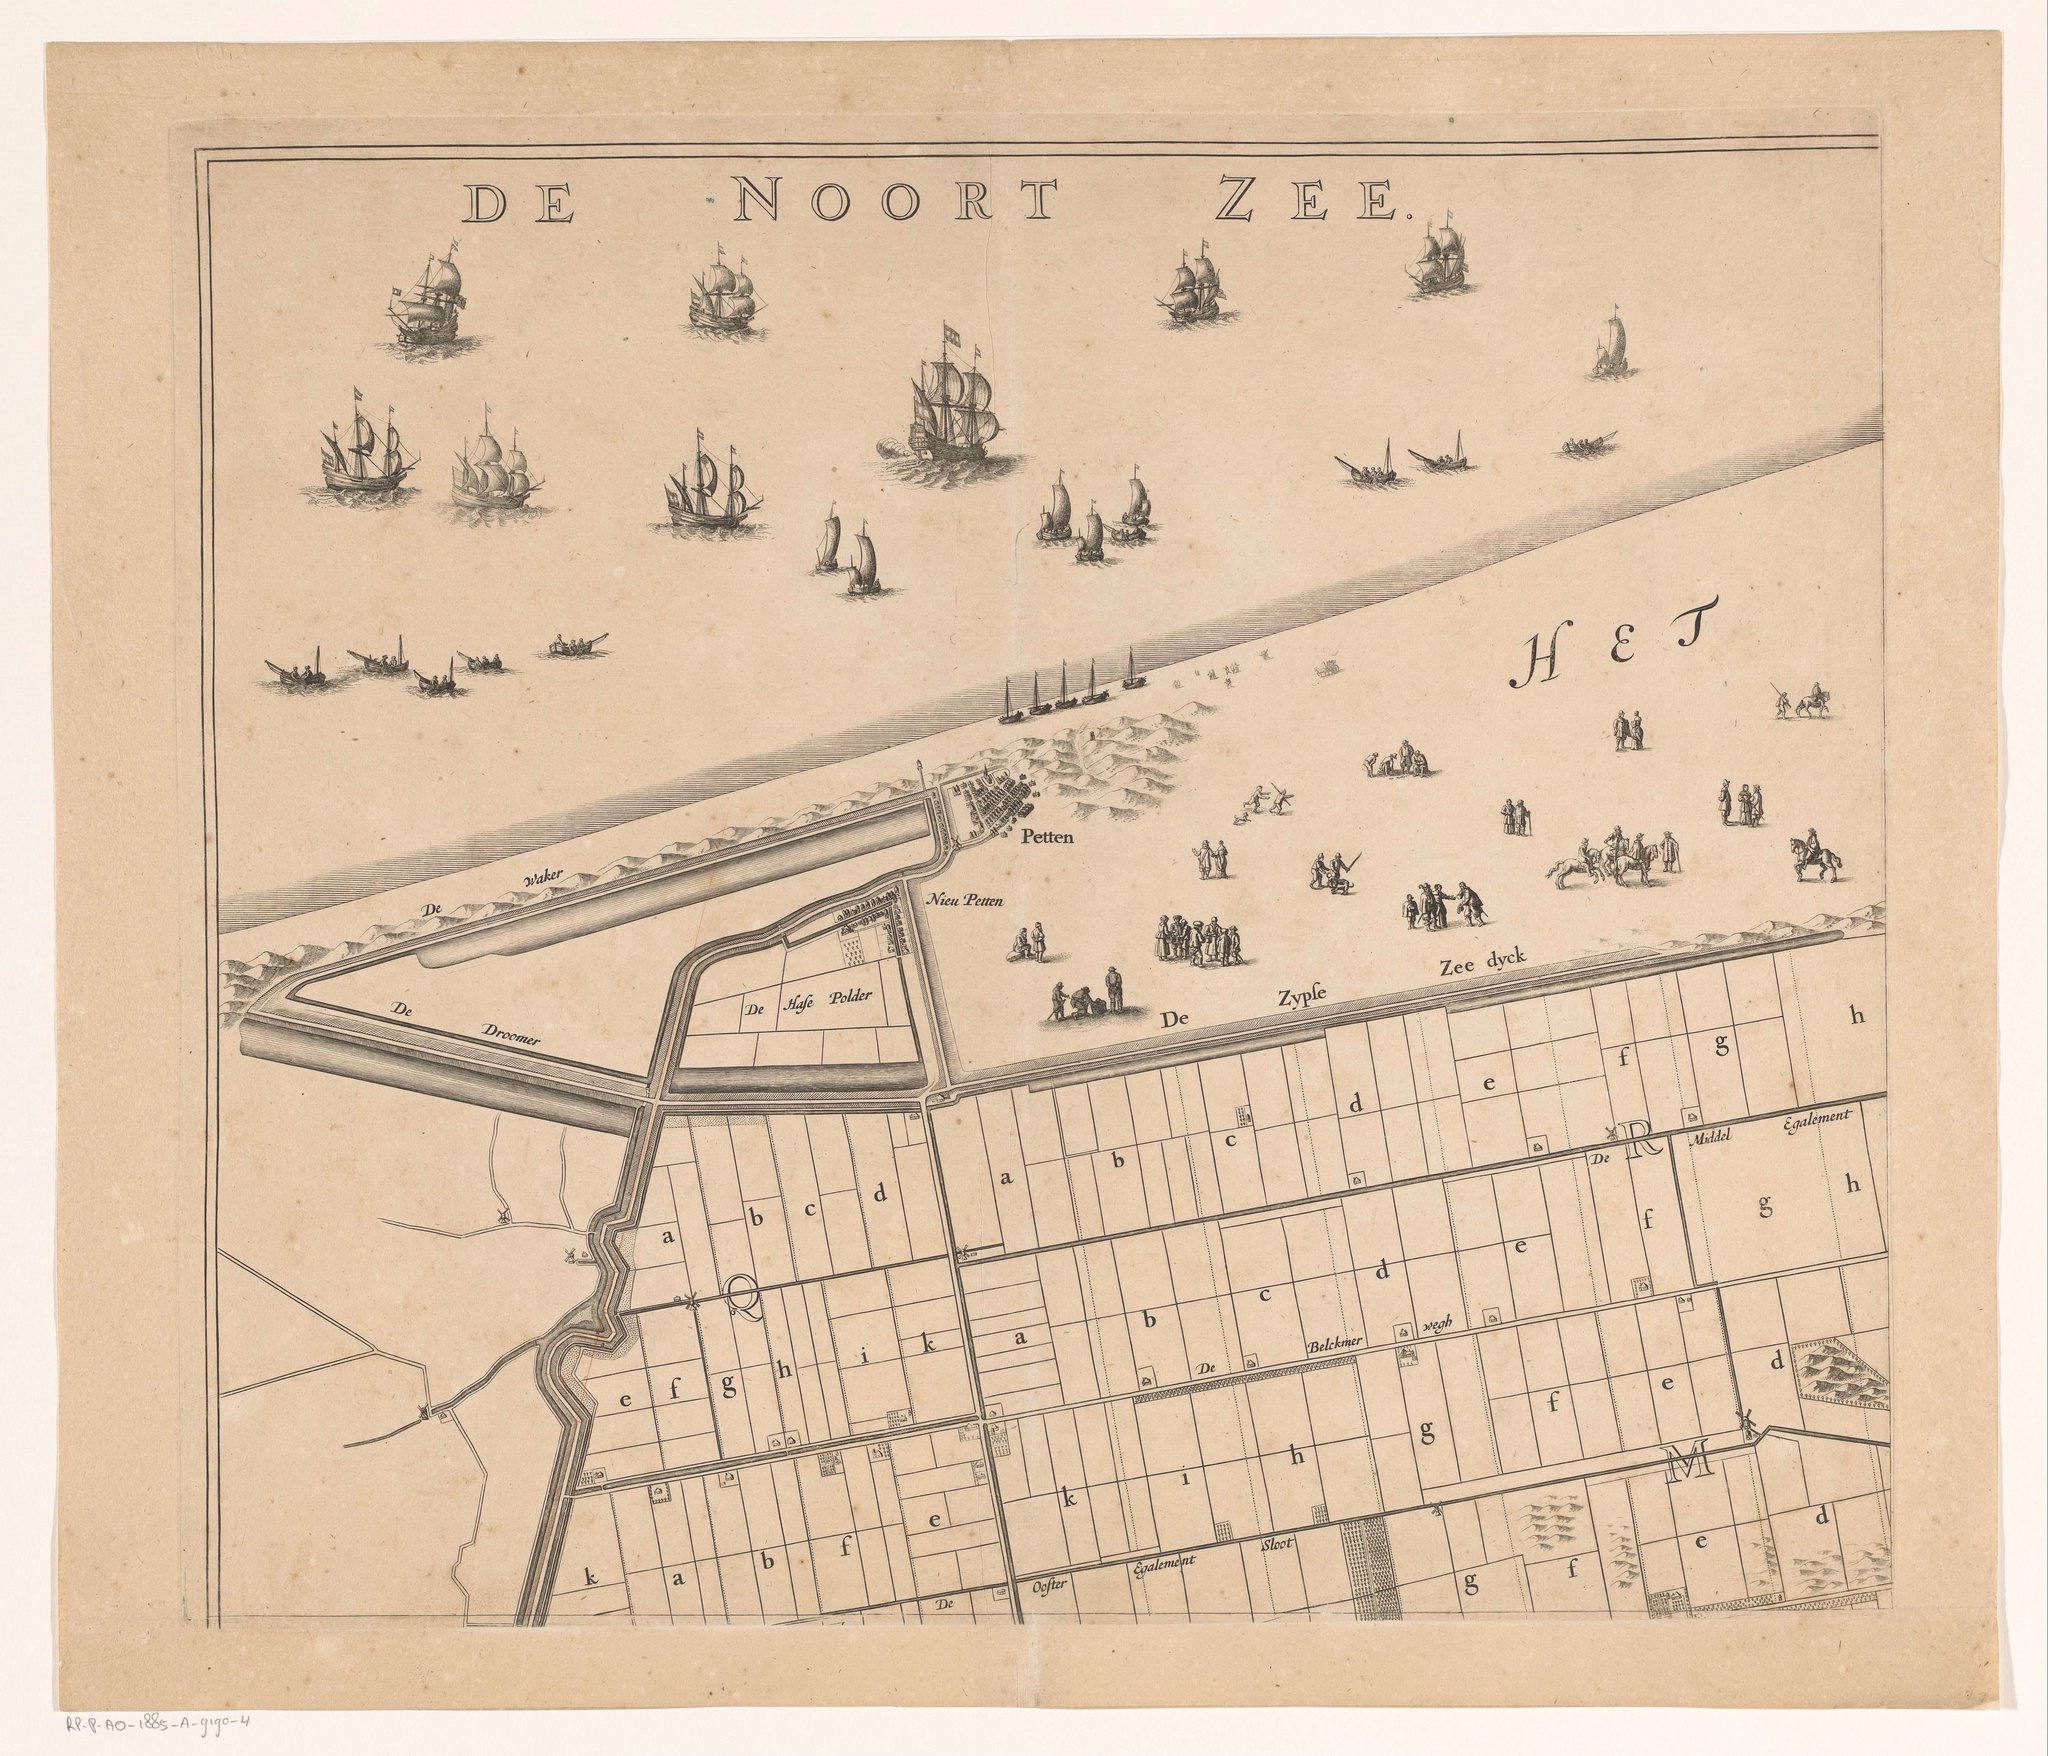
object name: print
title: Kaart van de Zijpe- en Hazepolder (deel linksboven)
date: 1665-1760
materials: paper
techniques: engraving, etching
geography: gouda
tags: maps of separate countries or regions, polder, reclaimed land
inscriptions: collector's mark: Lugt 2228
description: Deel (linksboven) van een kaart van de Zijpepolder.